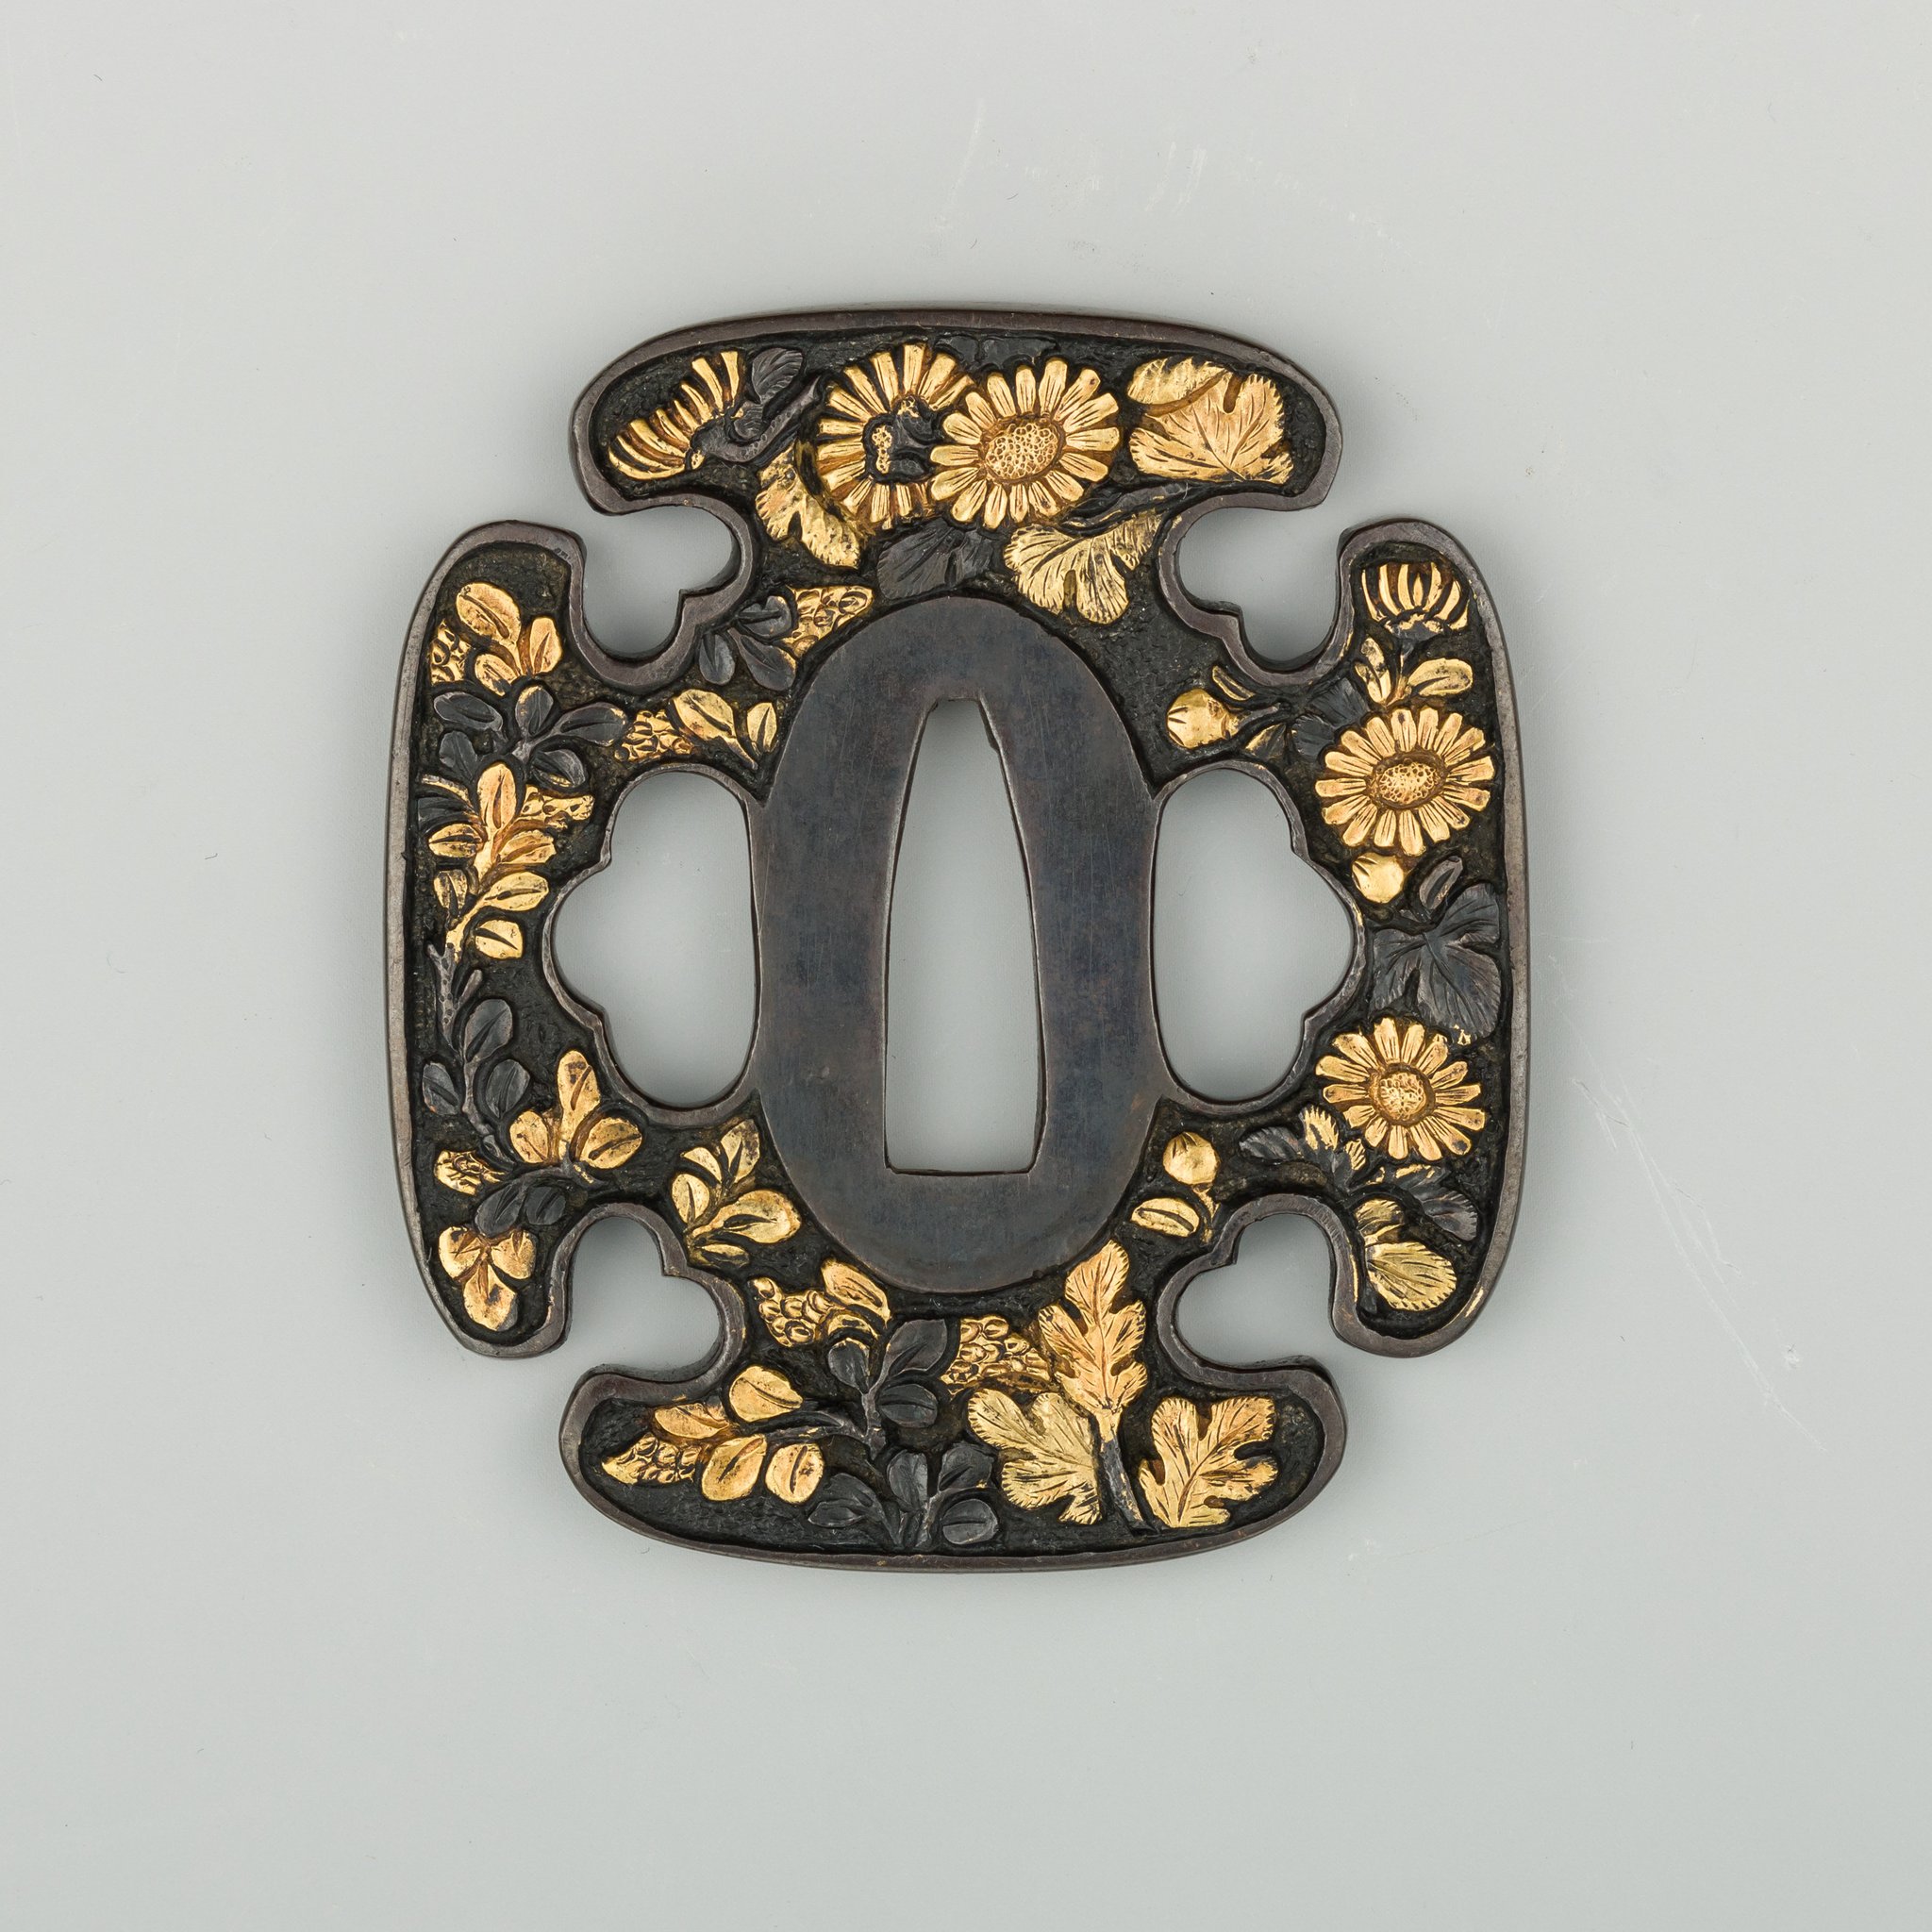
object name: sword guard tsuba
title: Sword Guard (Tsuba)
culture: japanese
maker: mino school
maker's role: fittings maker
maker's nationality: japanese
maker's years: 1600-1900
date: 1667-1733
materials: gold alloy, gold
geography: japan